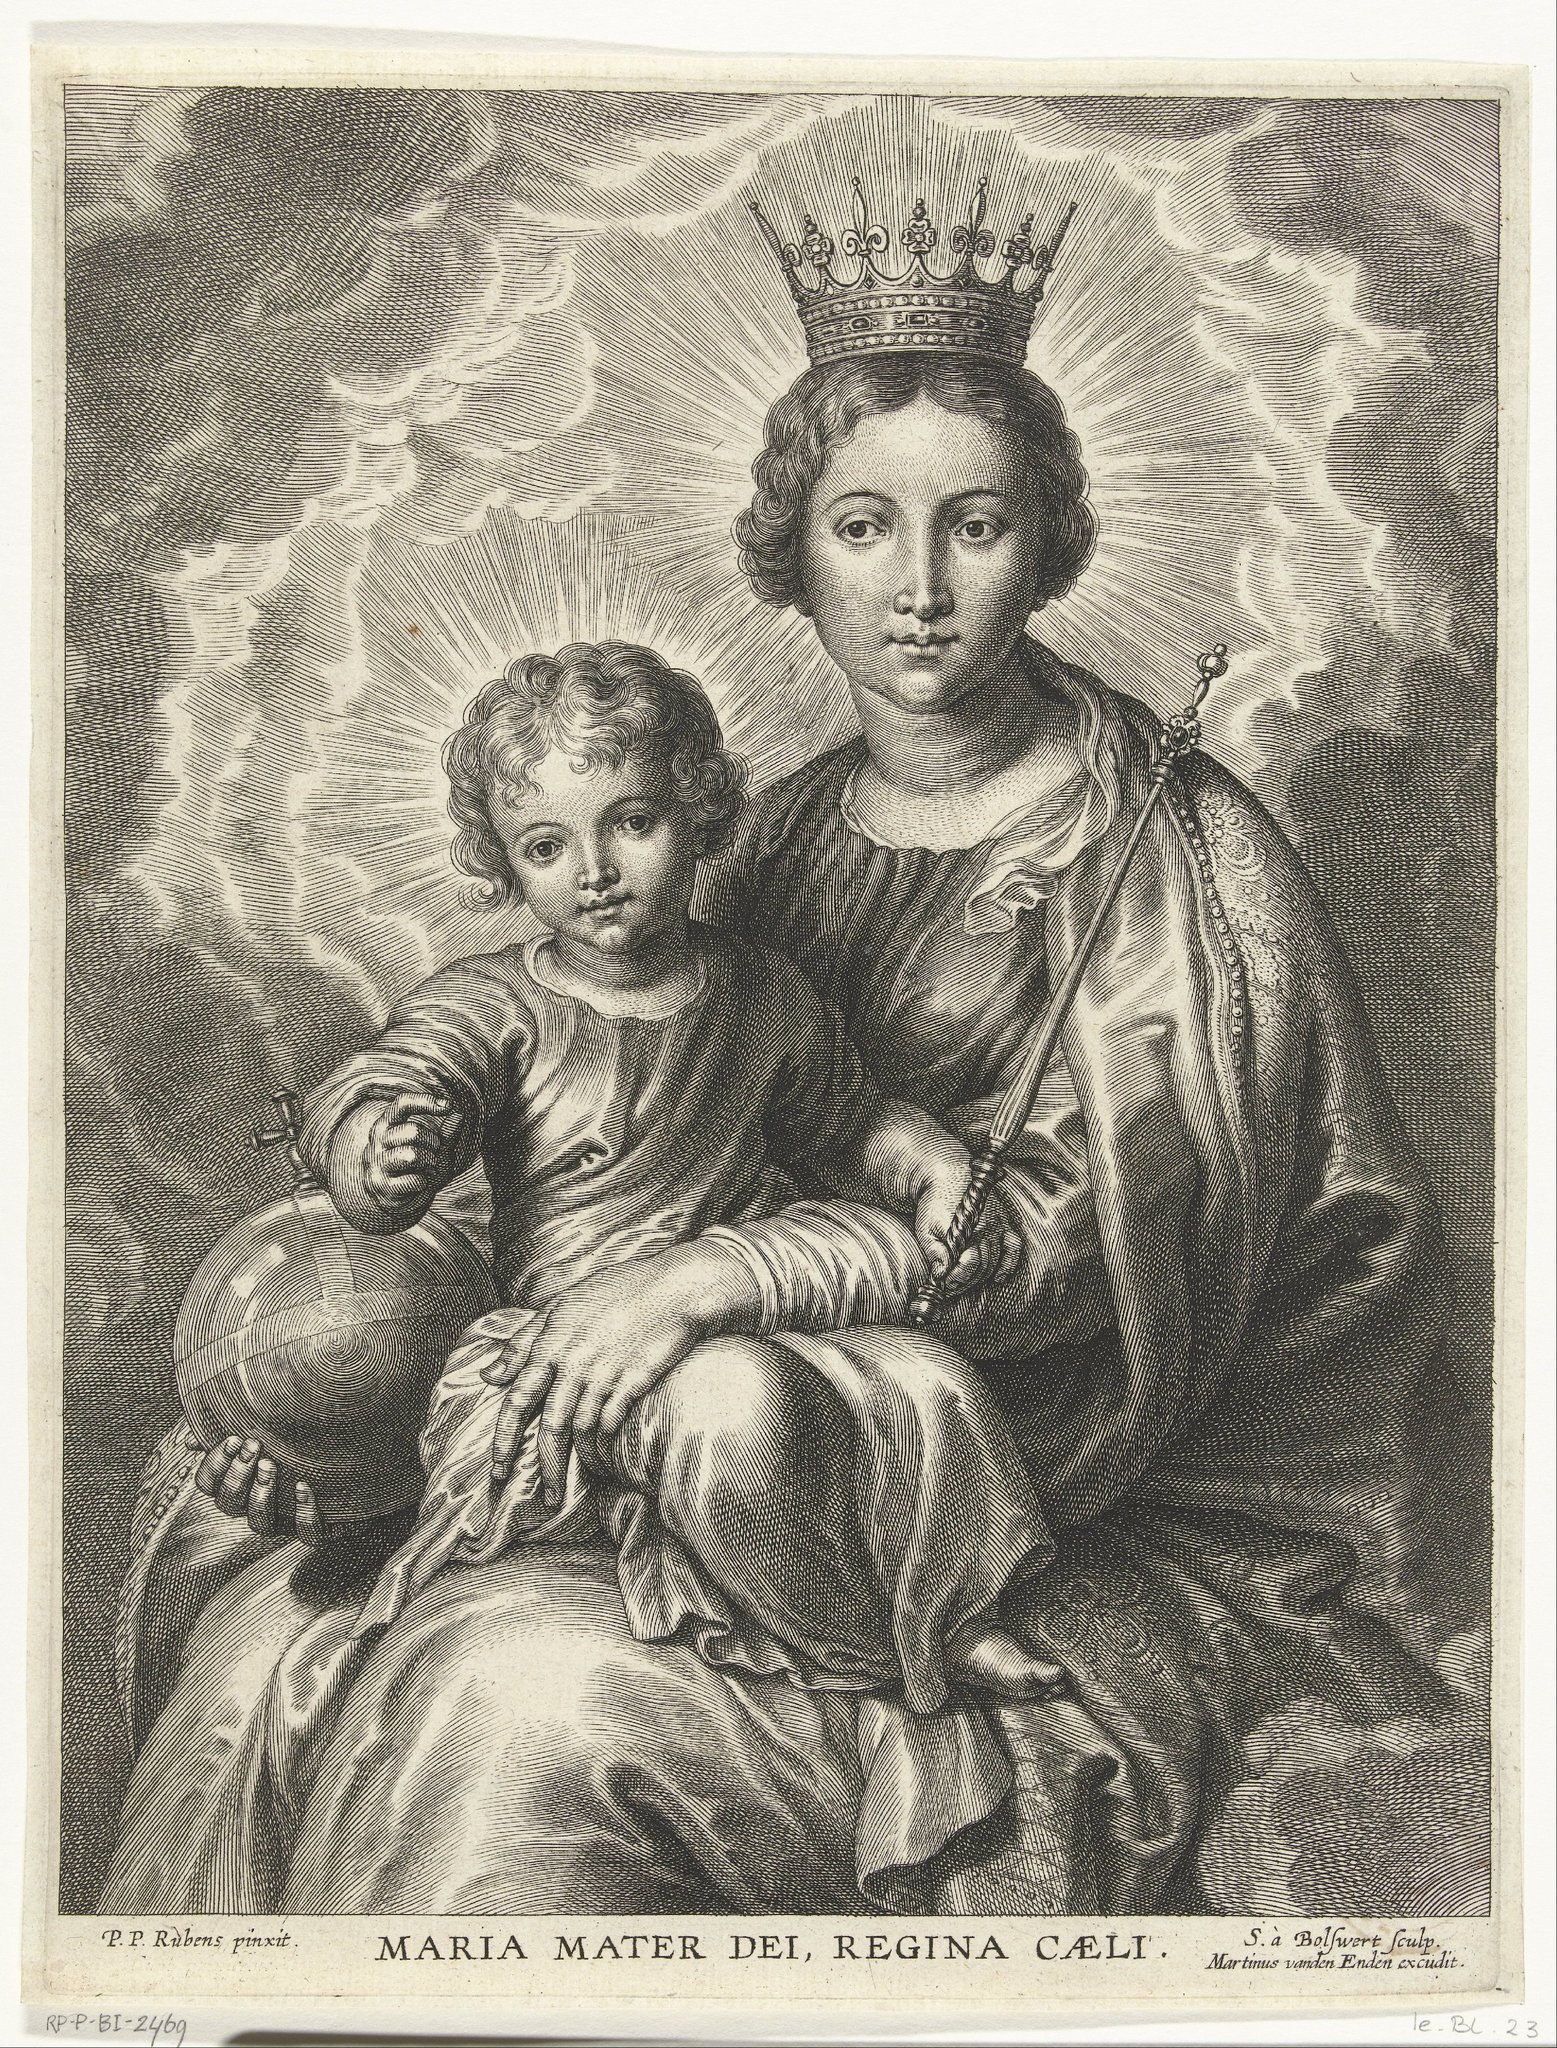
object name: print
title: Maria mater dei, regina caeli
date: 1596-1659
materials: paper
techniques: engraving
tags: mary sitting or enthroned, the christ-child in front of her in her lap (or in front of her bosom), 'regina coeli', 'regina angelorum', 'maestà' ~ madonna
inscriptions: collector's mark: Lugt 240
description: Maria met kroon en wereldbol als koningin van de hemel en kind met scepter